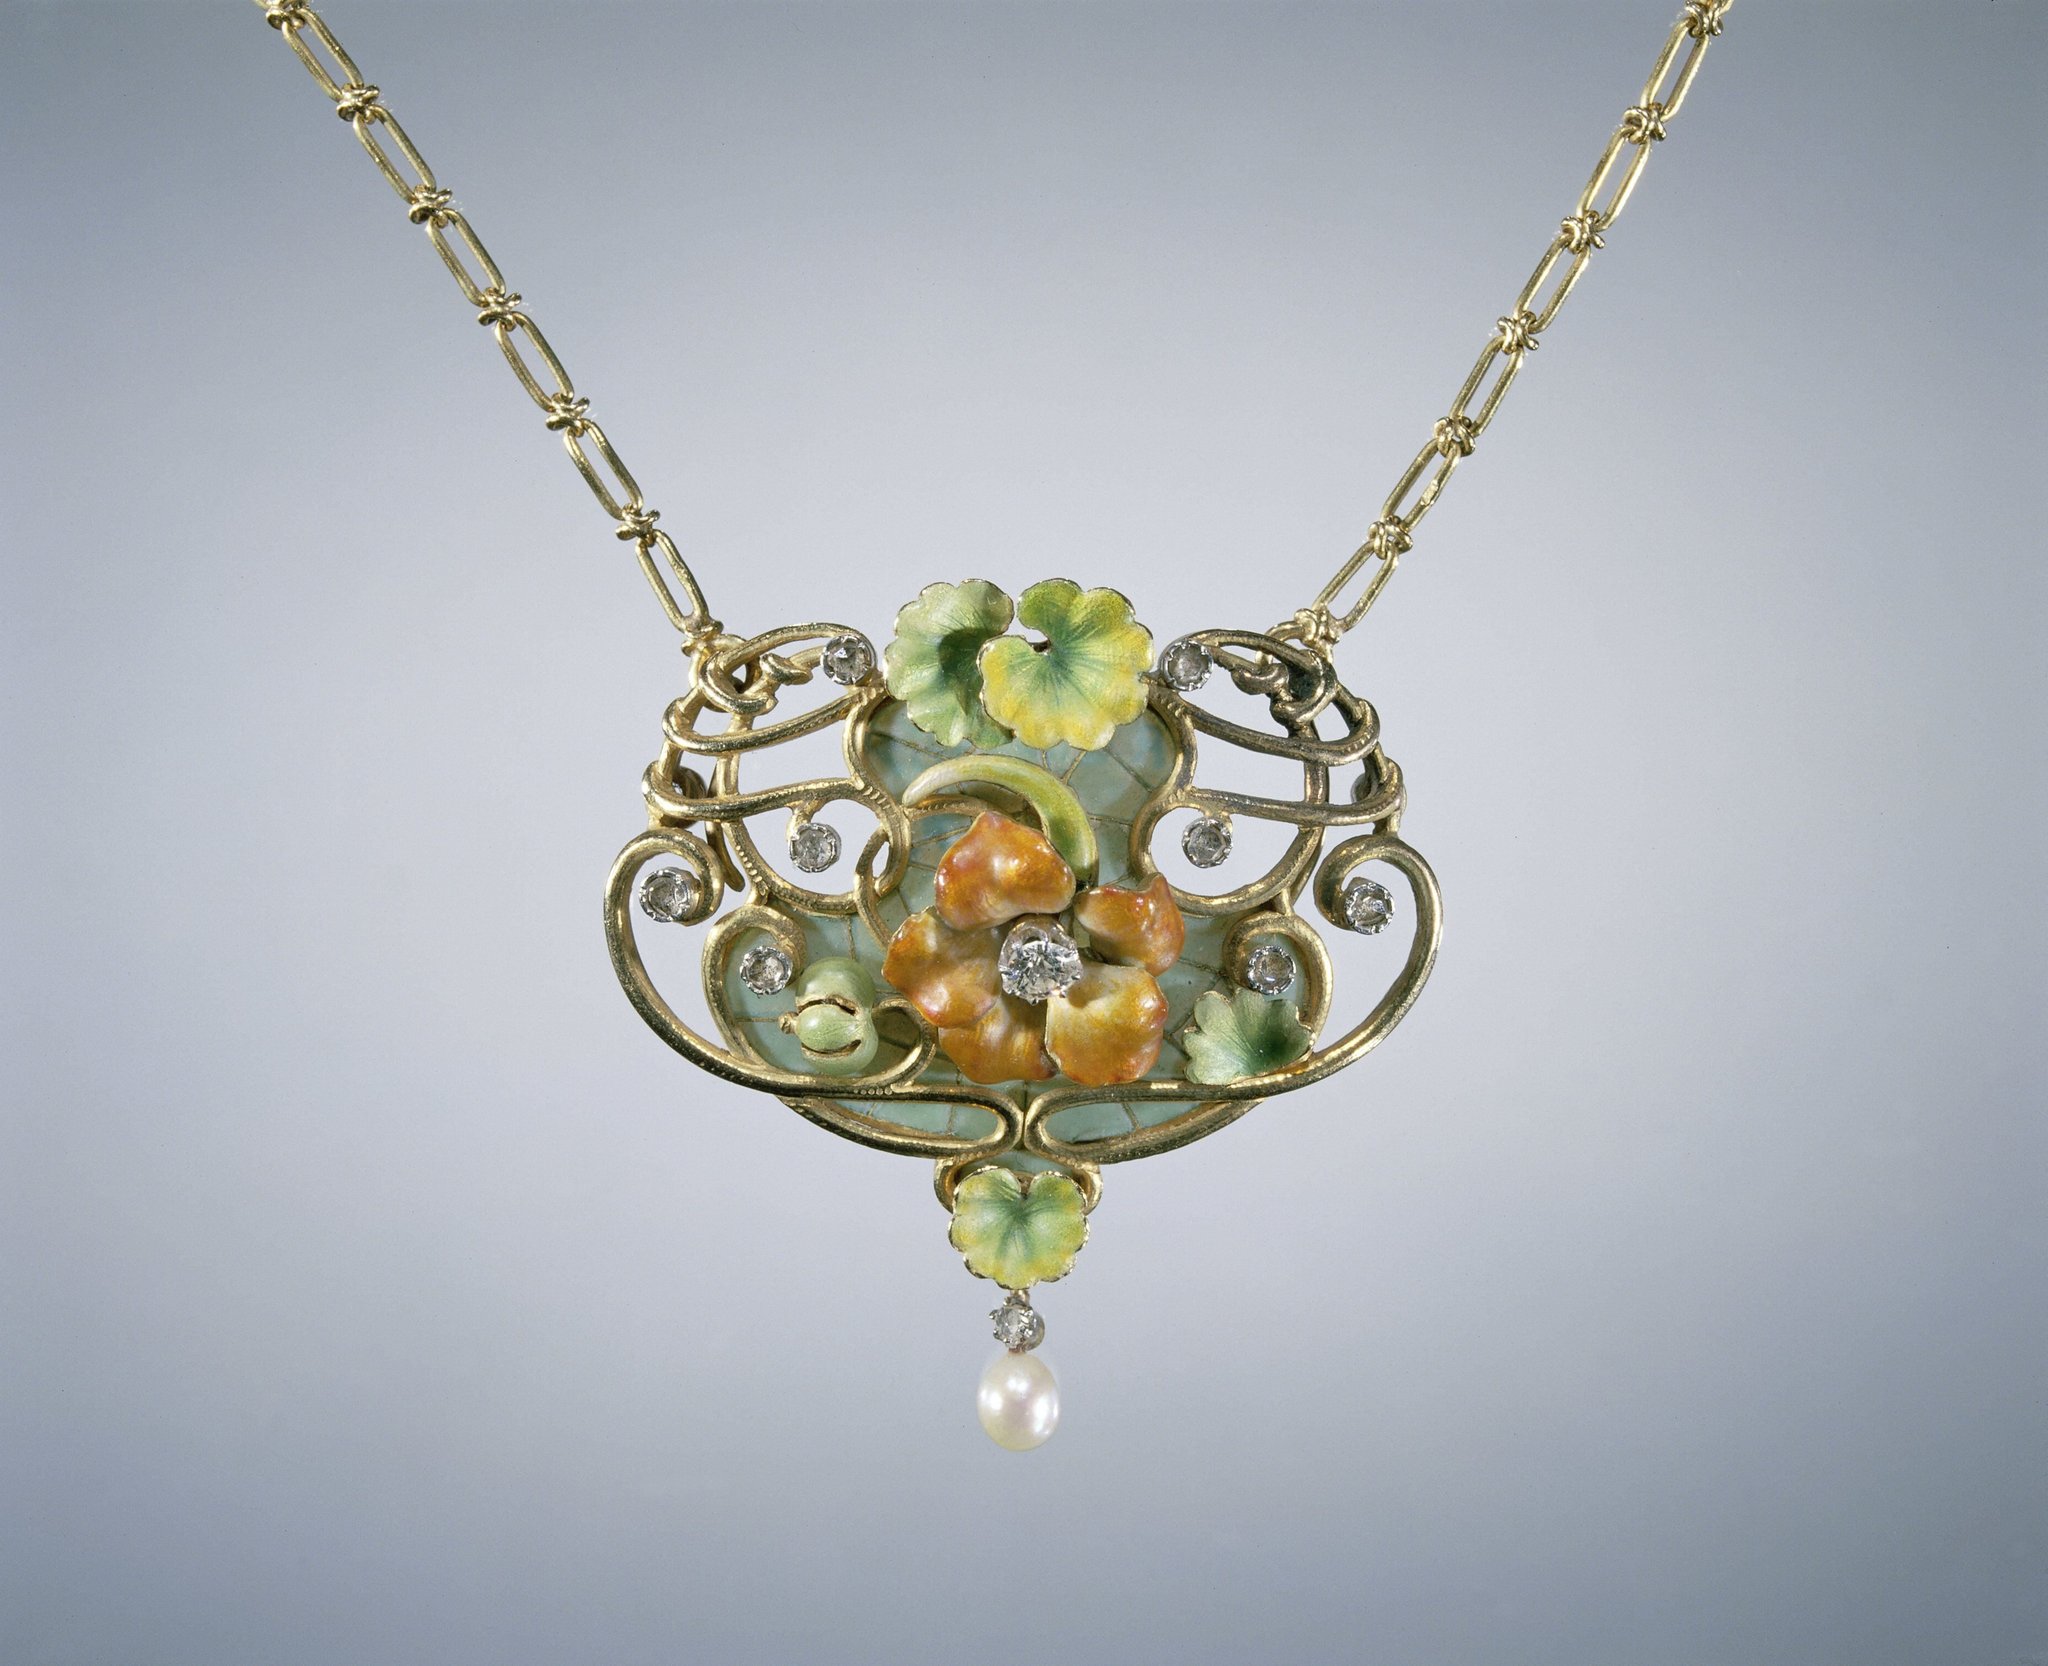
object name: jewellery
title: Collier van goud met diamanten, parels en email. Versierd met in felle kleuren geëmailleerde bloemen van de Oostindische kers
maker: Anonymous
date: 1900-1910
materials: diamond, gold, pearl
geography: paris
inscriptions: maker's mark: ‘onduidelijk’, alloy mark: ‘adelaarskop naar rechts (vanaf 1847)’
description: Necklace. Gold, diamonds, pearl and enamel. Paris, c. 1900 - 1910.